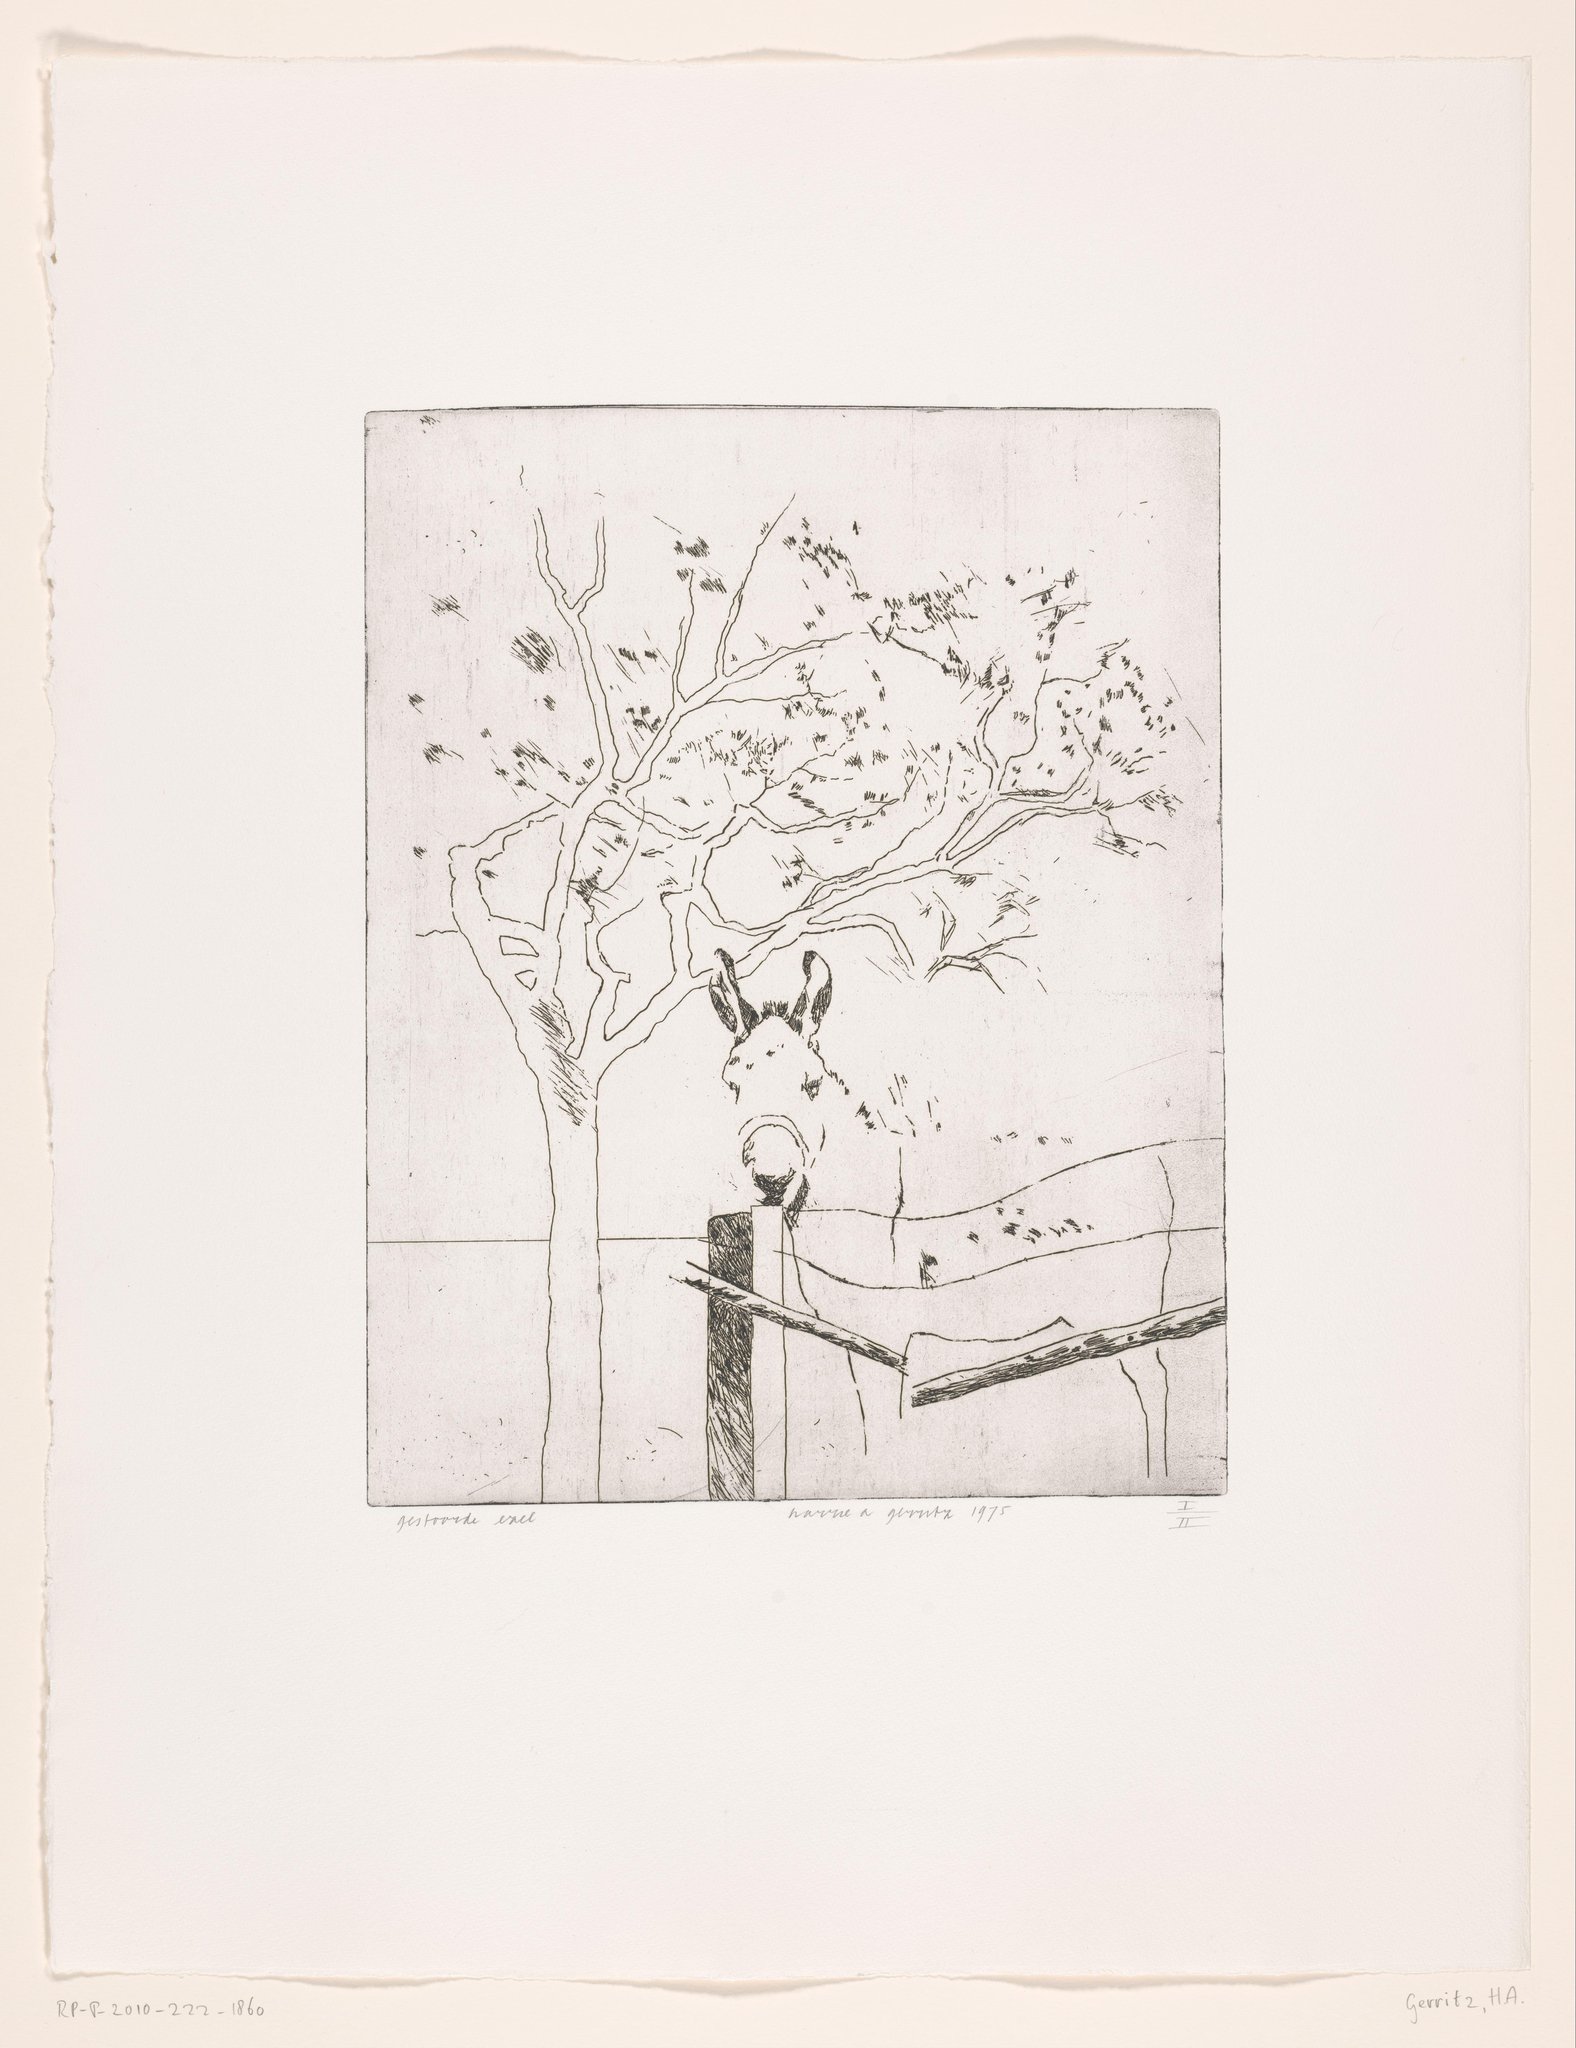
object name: print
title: Gestoorde ezel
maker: harrie a. gerritz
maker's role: draughtsman, painter, print maker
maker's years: 1940-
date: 1975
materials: paper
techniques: etching, intaglio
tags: trees, ass, donkey, receiver, fence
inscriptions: collector's mark: Lugt 2228, inscription: ‘PC’